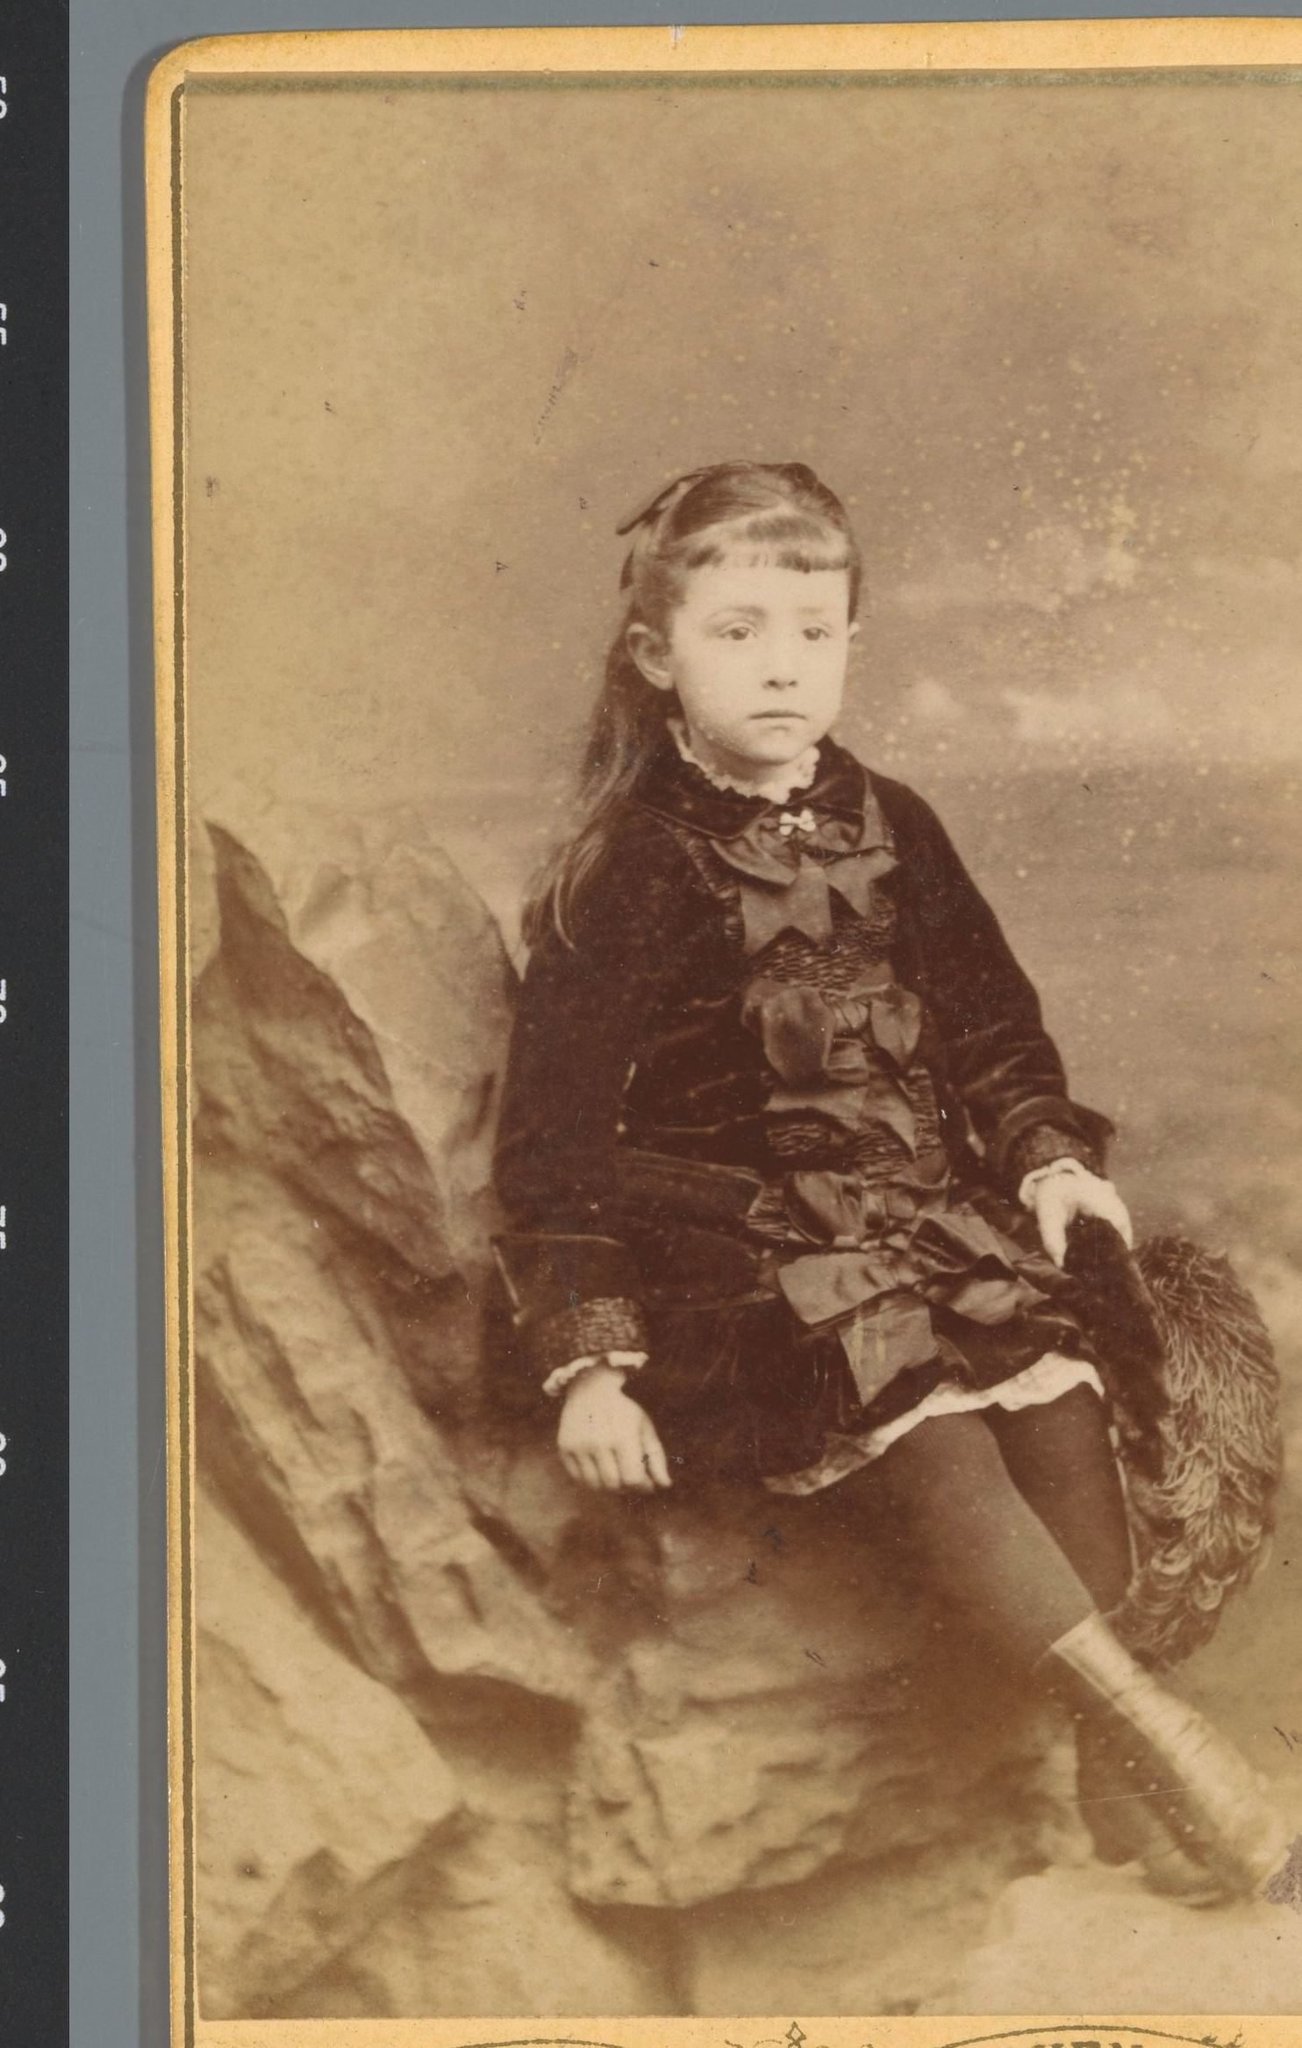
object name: carte de visite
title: Portret van een onbekend meisje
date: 1855-1885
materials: cardboard, paper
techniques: albumen print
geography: rouen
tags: girl (child between toddler and youth), anonymous historical person portrayed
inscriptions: inscription: ‘Tous les cliches sont conservés’, number: ‘No 96218’, address: ‘ROUEN/ Place des Carmes, 46’